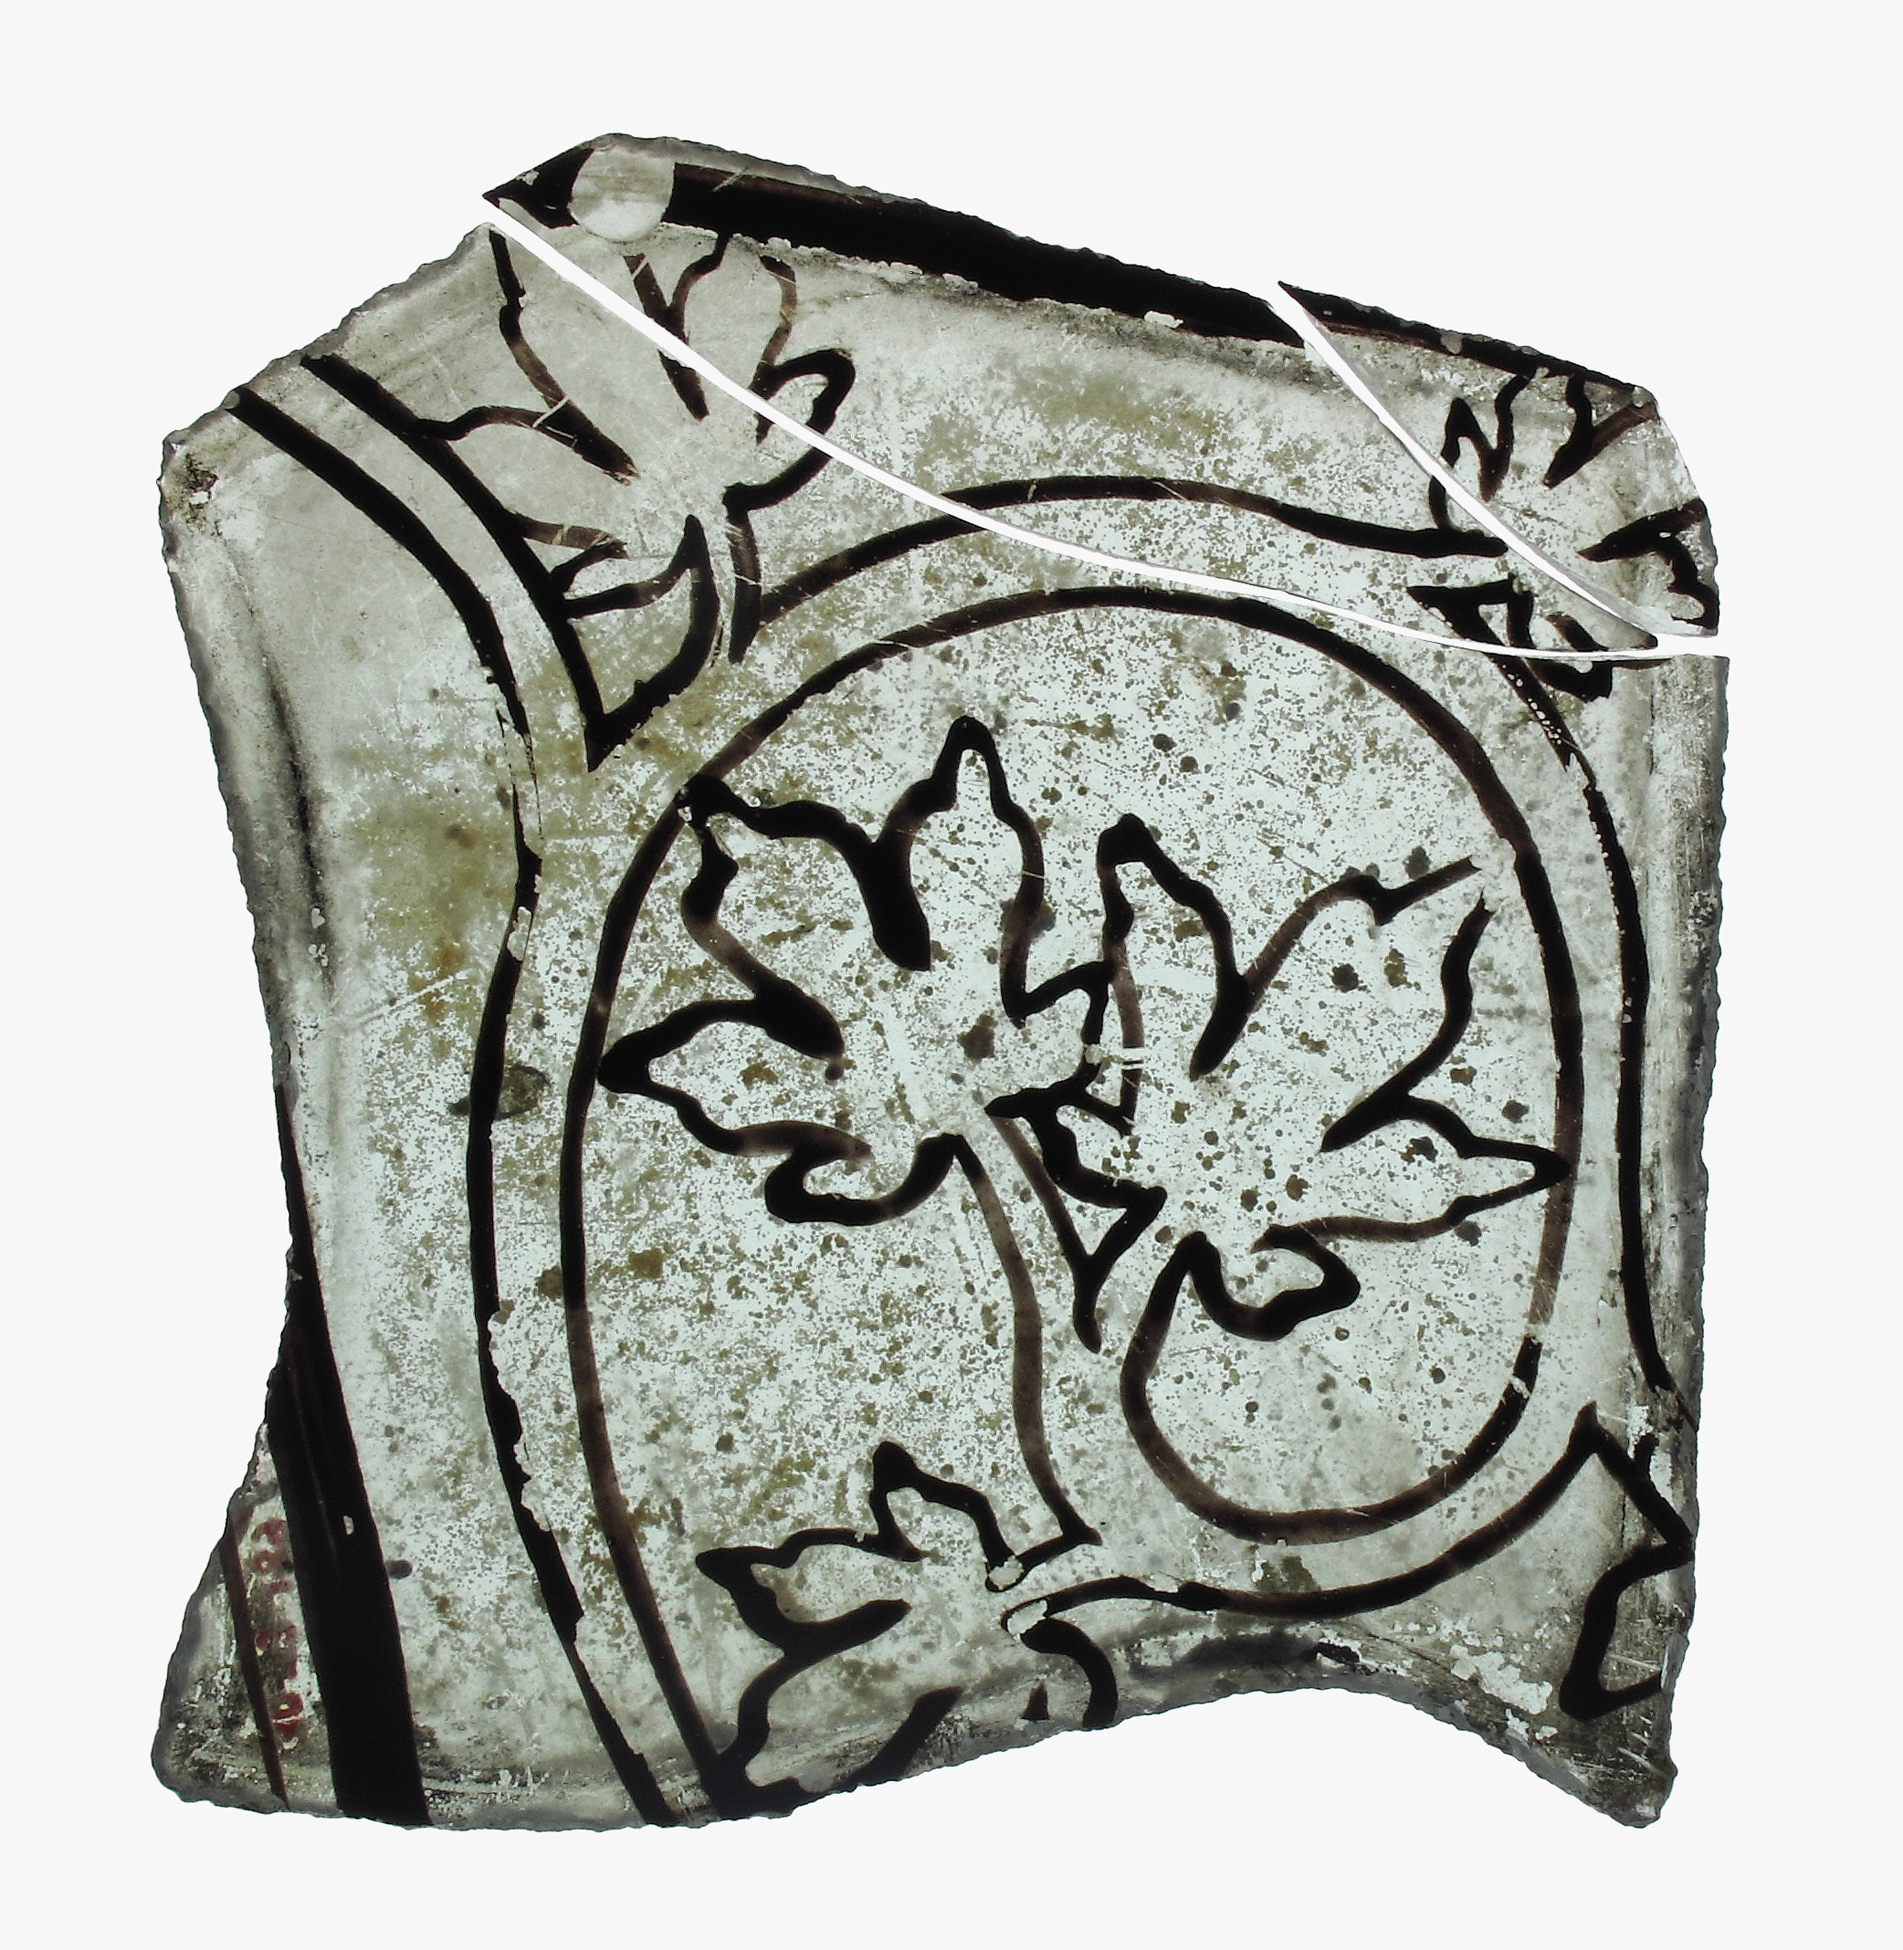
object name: fragment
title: Glass Fragments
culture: european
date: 1301-1500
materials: glass